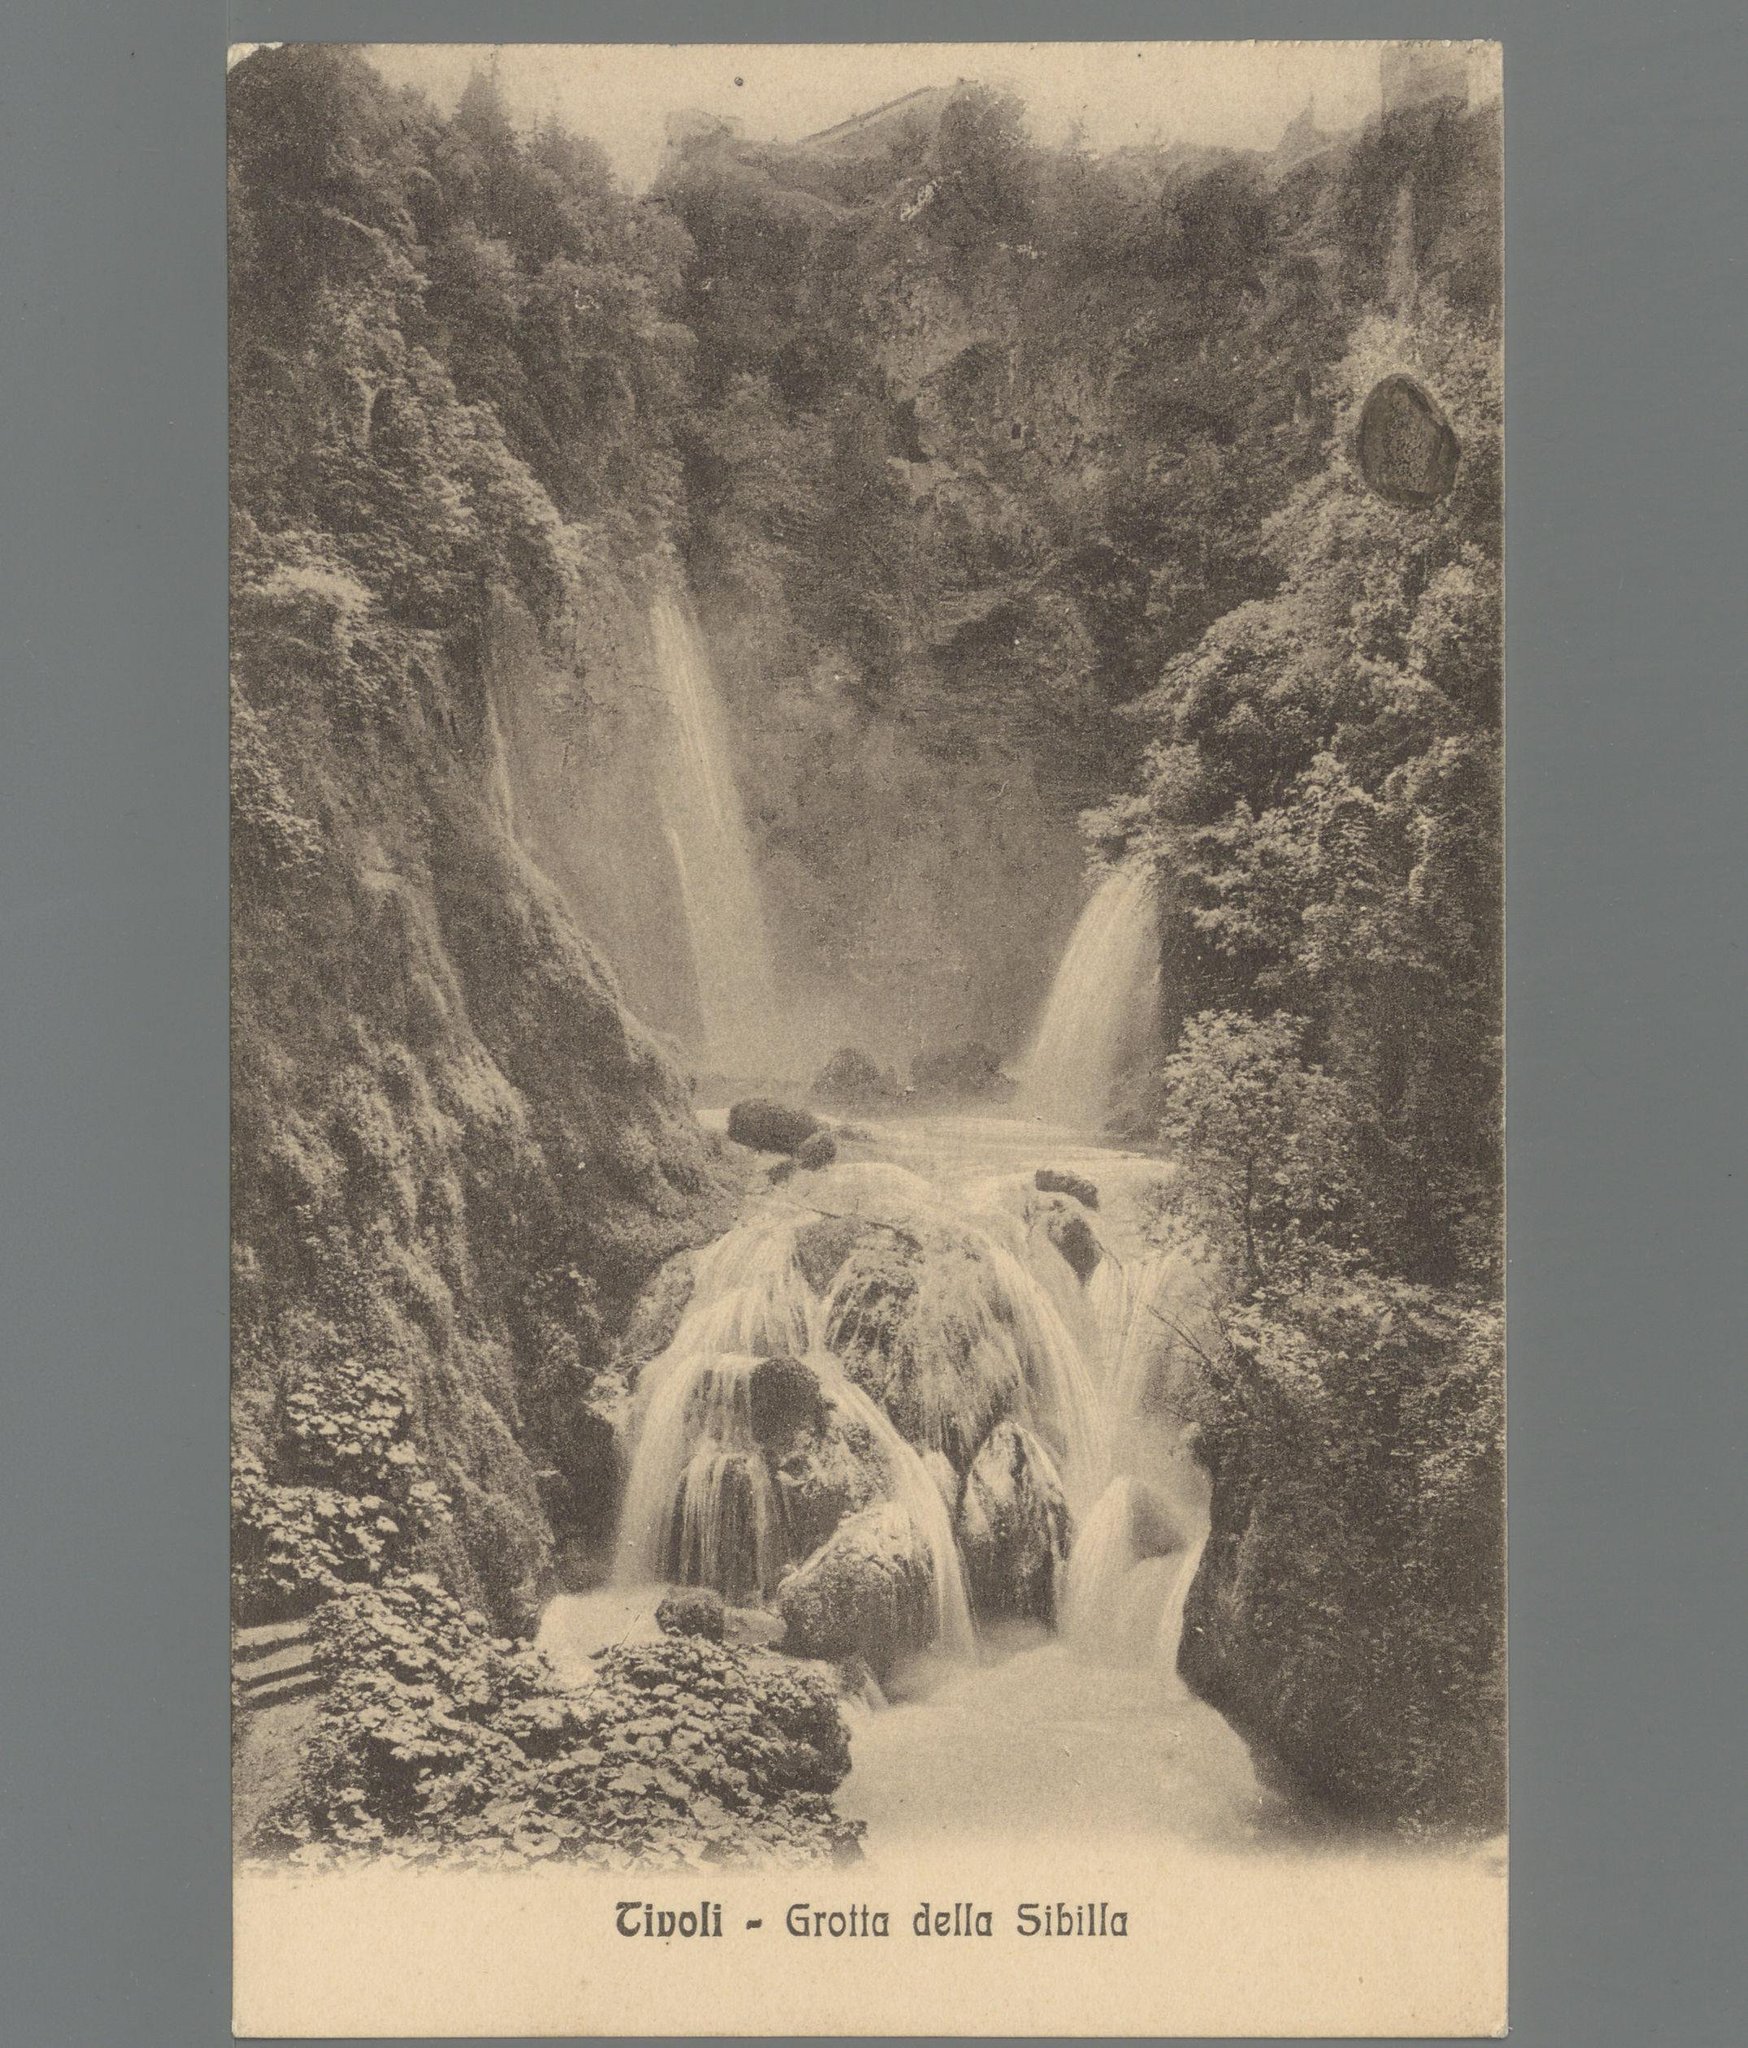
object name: ansichtkaart, prentbriefkaart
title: Tivoli. Grotta della Sibilla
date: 1906-1920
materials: cardboard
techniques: photograph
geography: tivoli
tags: trees, waterfall, tivoli